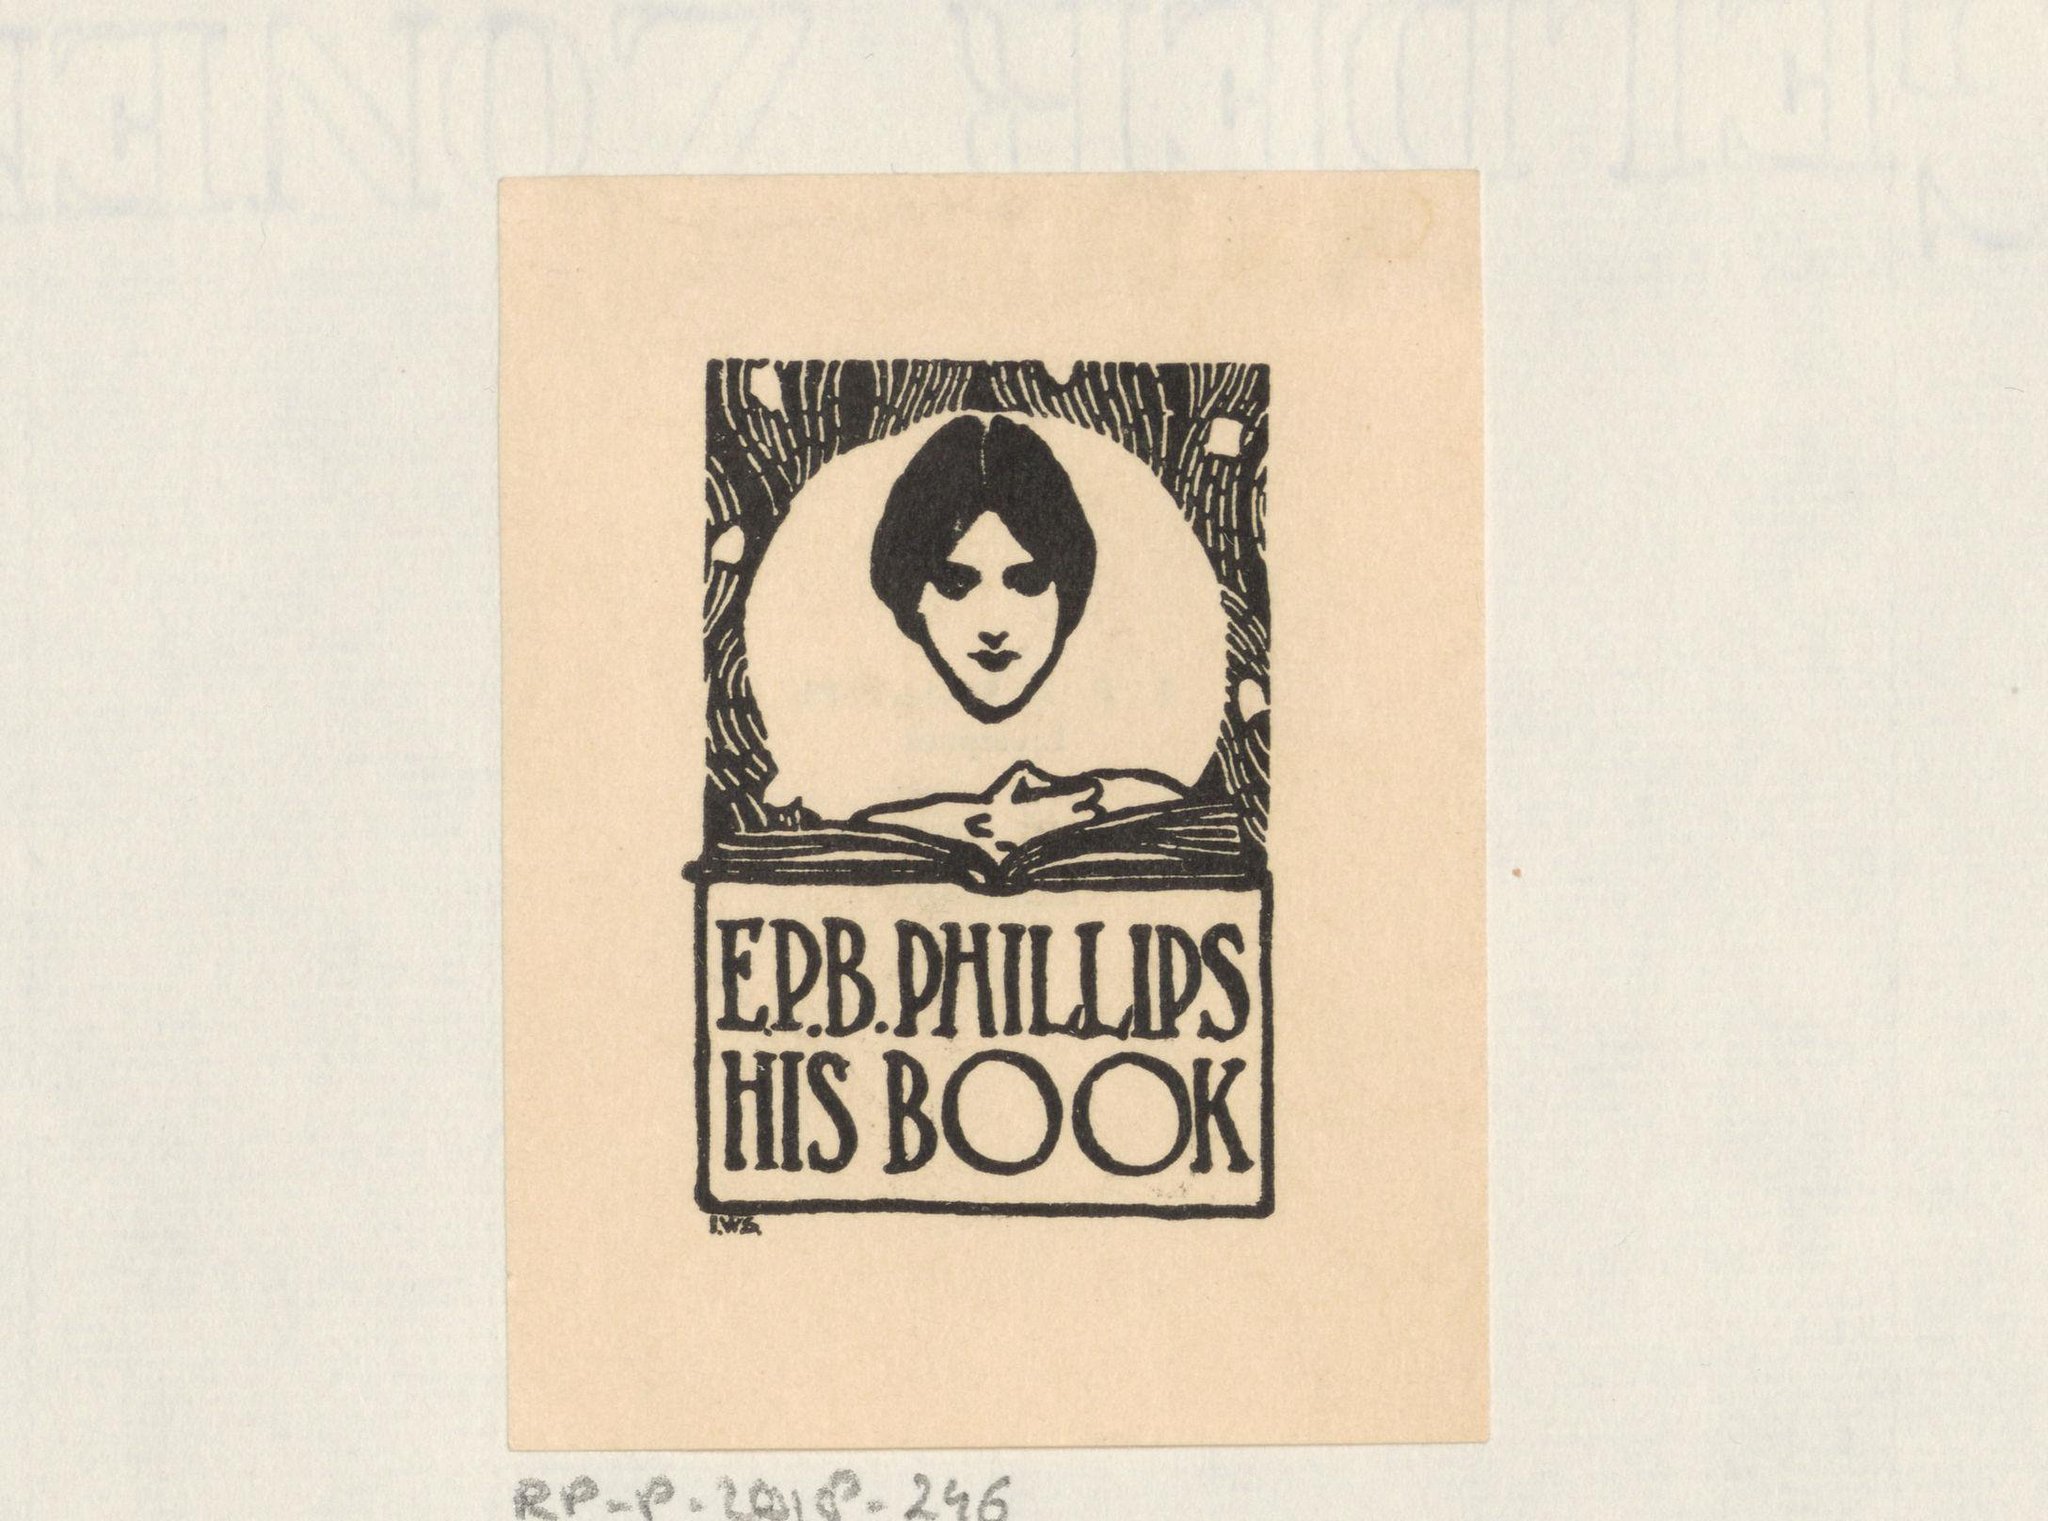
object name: bookplate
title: Ex libris van E.P.B. Phillips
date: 1889-1939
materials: paper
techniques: printing block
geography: edinburgh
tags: book, head (human) - aa - female human figure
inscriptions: inscription: ‘E.P.B. Phillips/ Liverpool/ by J.W. Simpson/ Edinburgh’